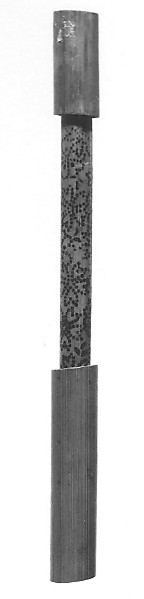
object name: osobuki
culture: japanese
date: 1801-1900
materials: bamboo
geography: japan